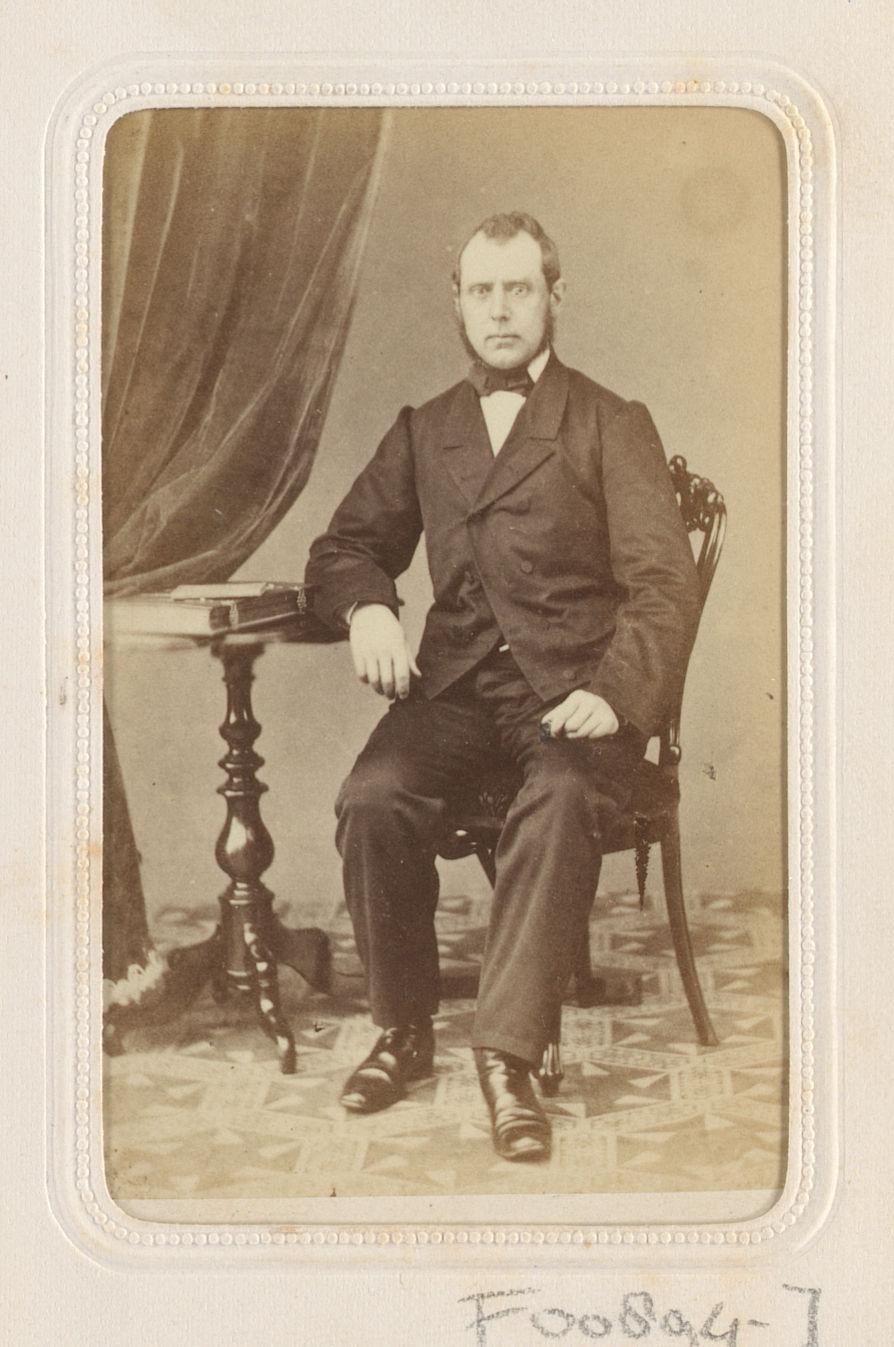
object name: carte de visite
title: Portret van een zittende man aan een tafel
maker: jacobus van gorkom (jr.)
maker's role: print maker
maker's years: 1827-1880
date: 1862-1871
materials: cardboard, photographic support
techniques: albumen print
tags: sitting figure, adult man, historical persons, table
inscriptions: inscription: ‘[...] Gorkum Jr./ Rotterdam’